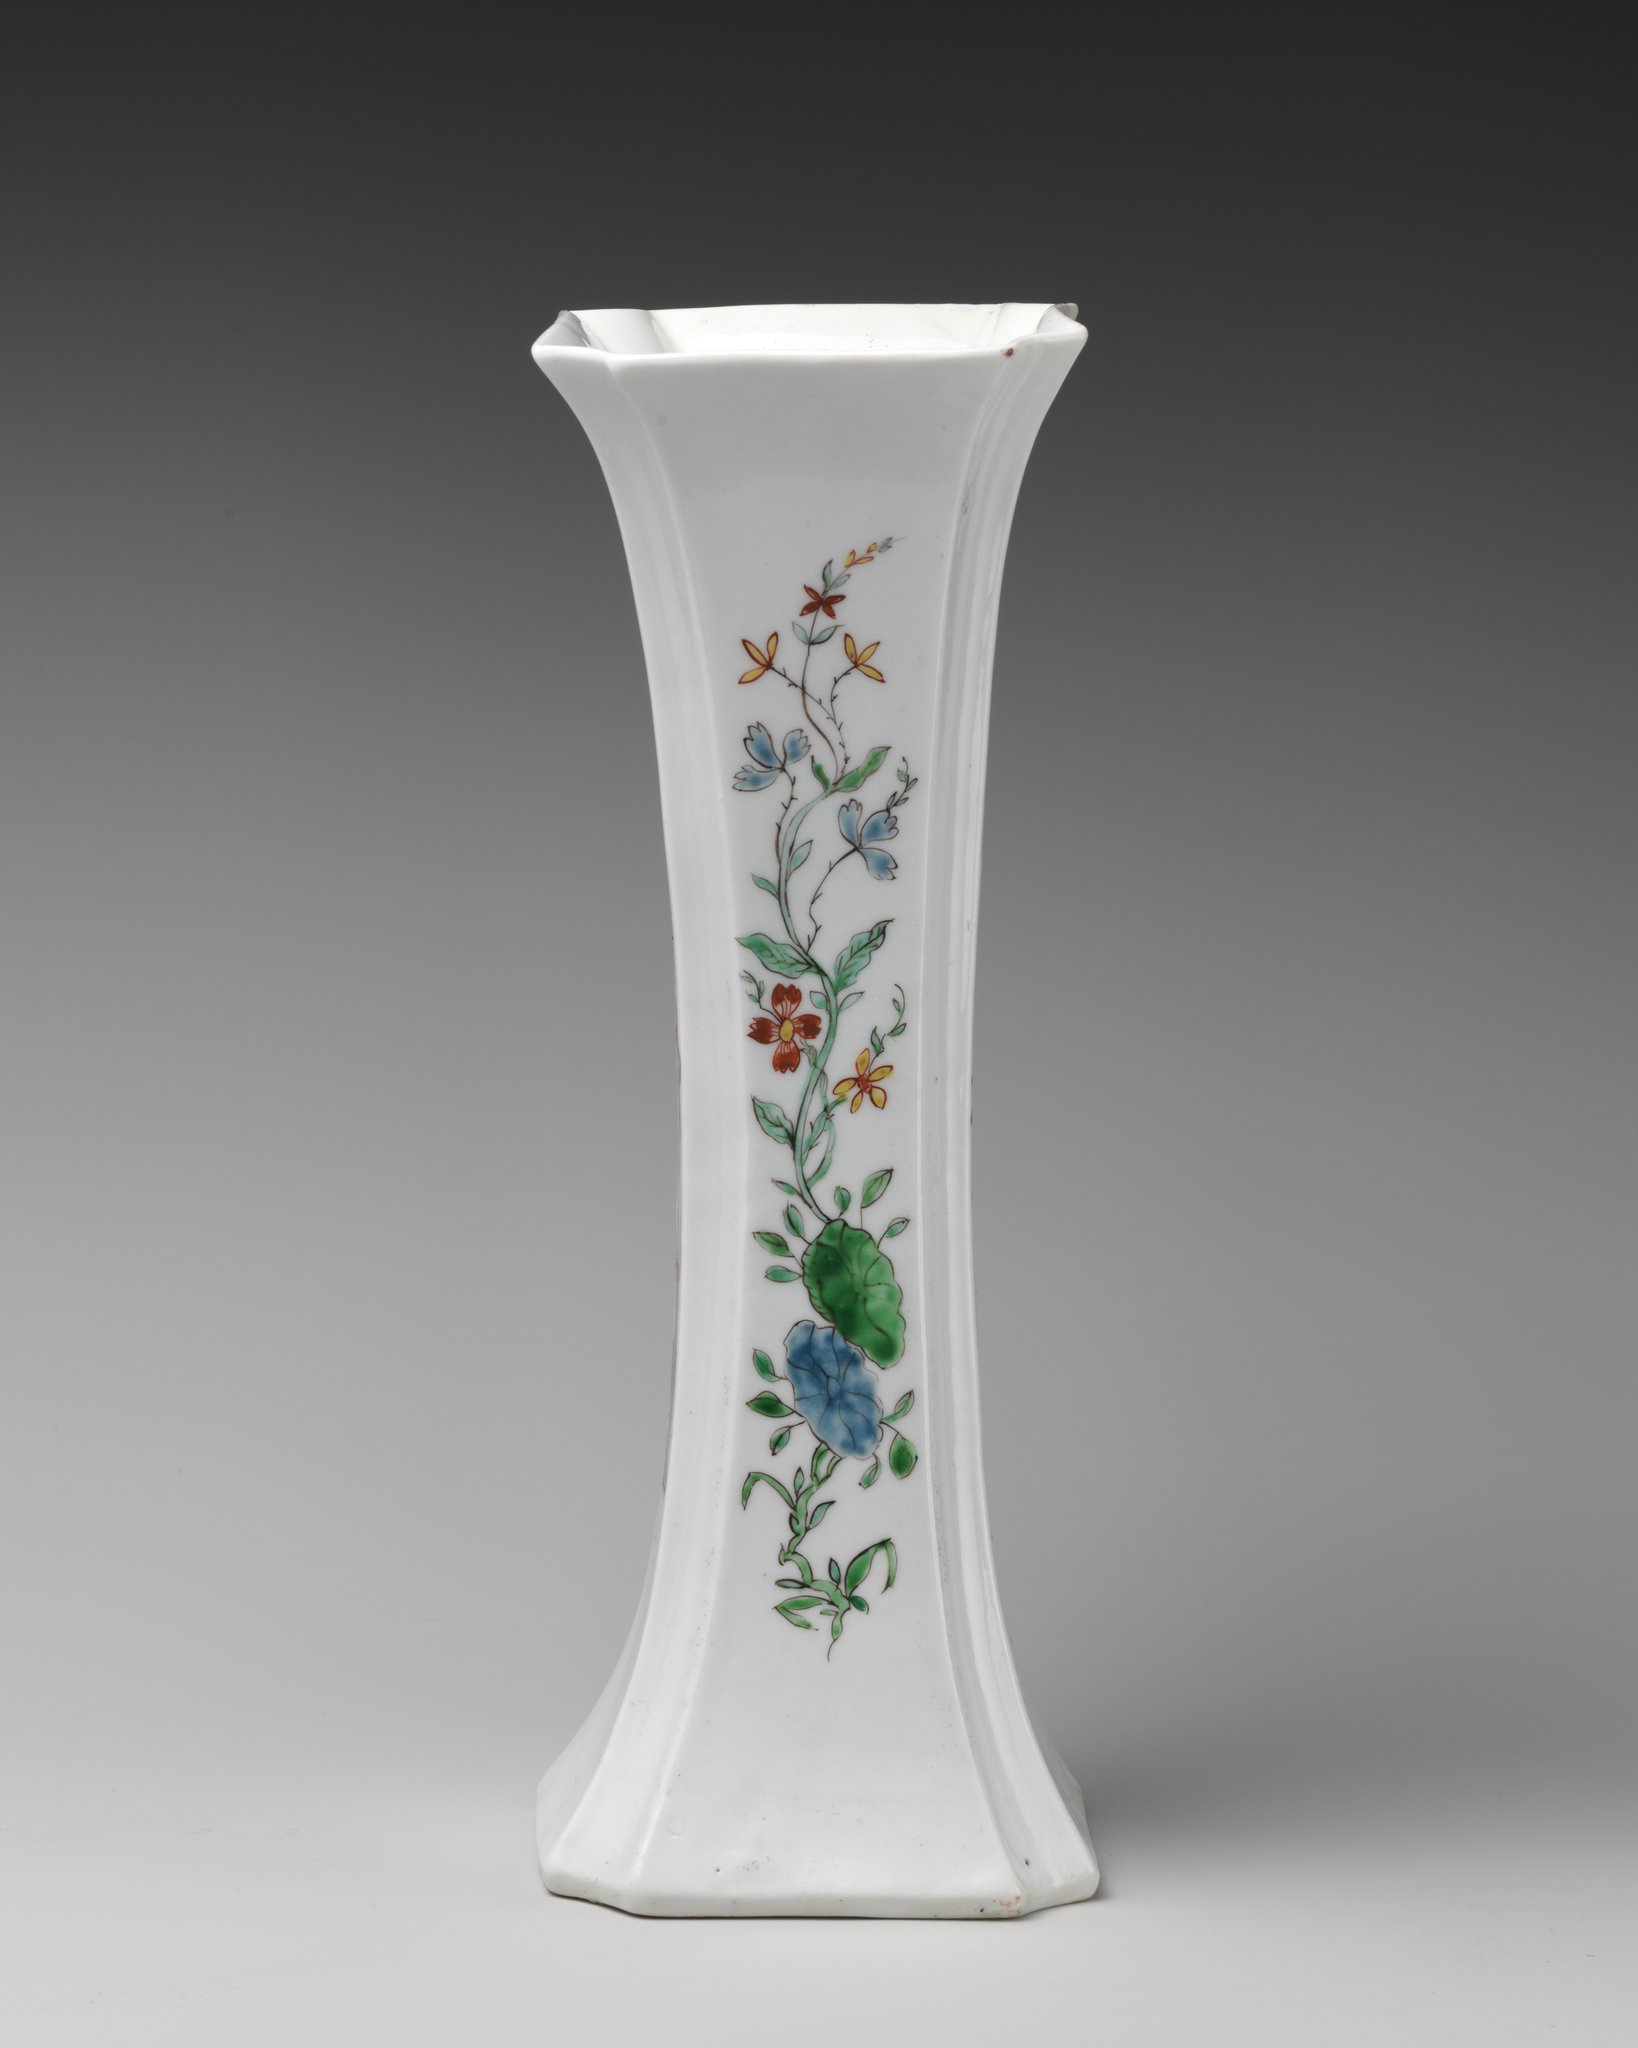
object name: garniture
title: Beaker (part of a garniture)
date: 1752-1753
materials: enamel, soft paste porcelain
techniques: polychrome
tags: flowers